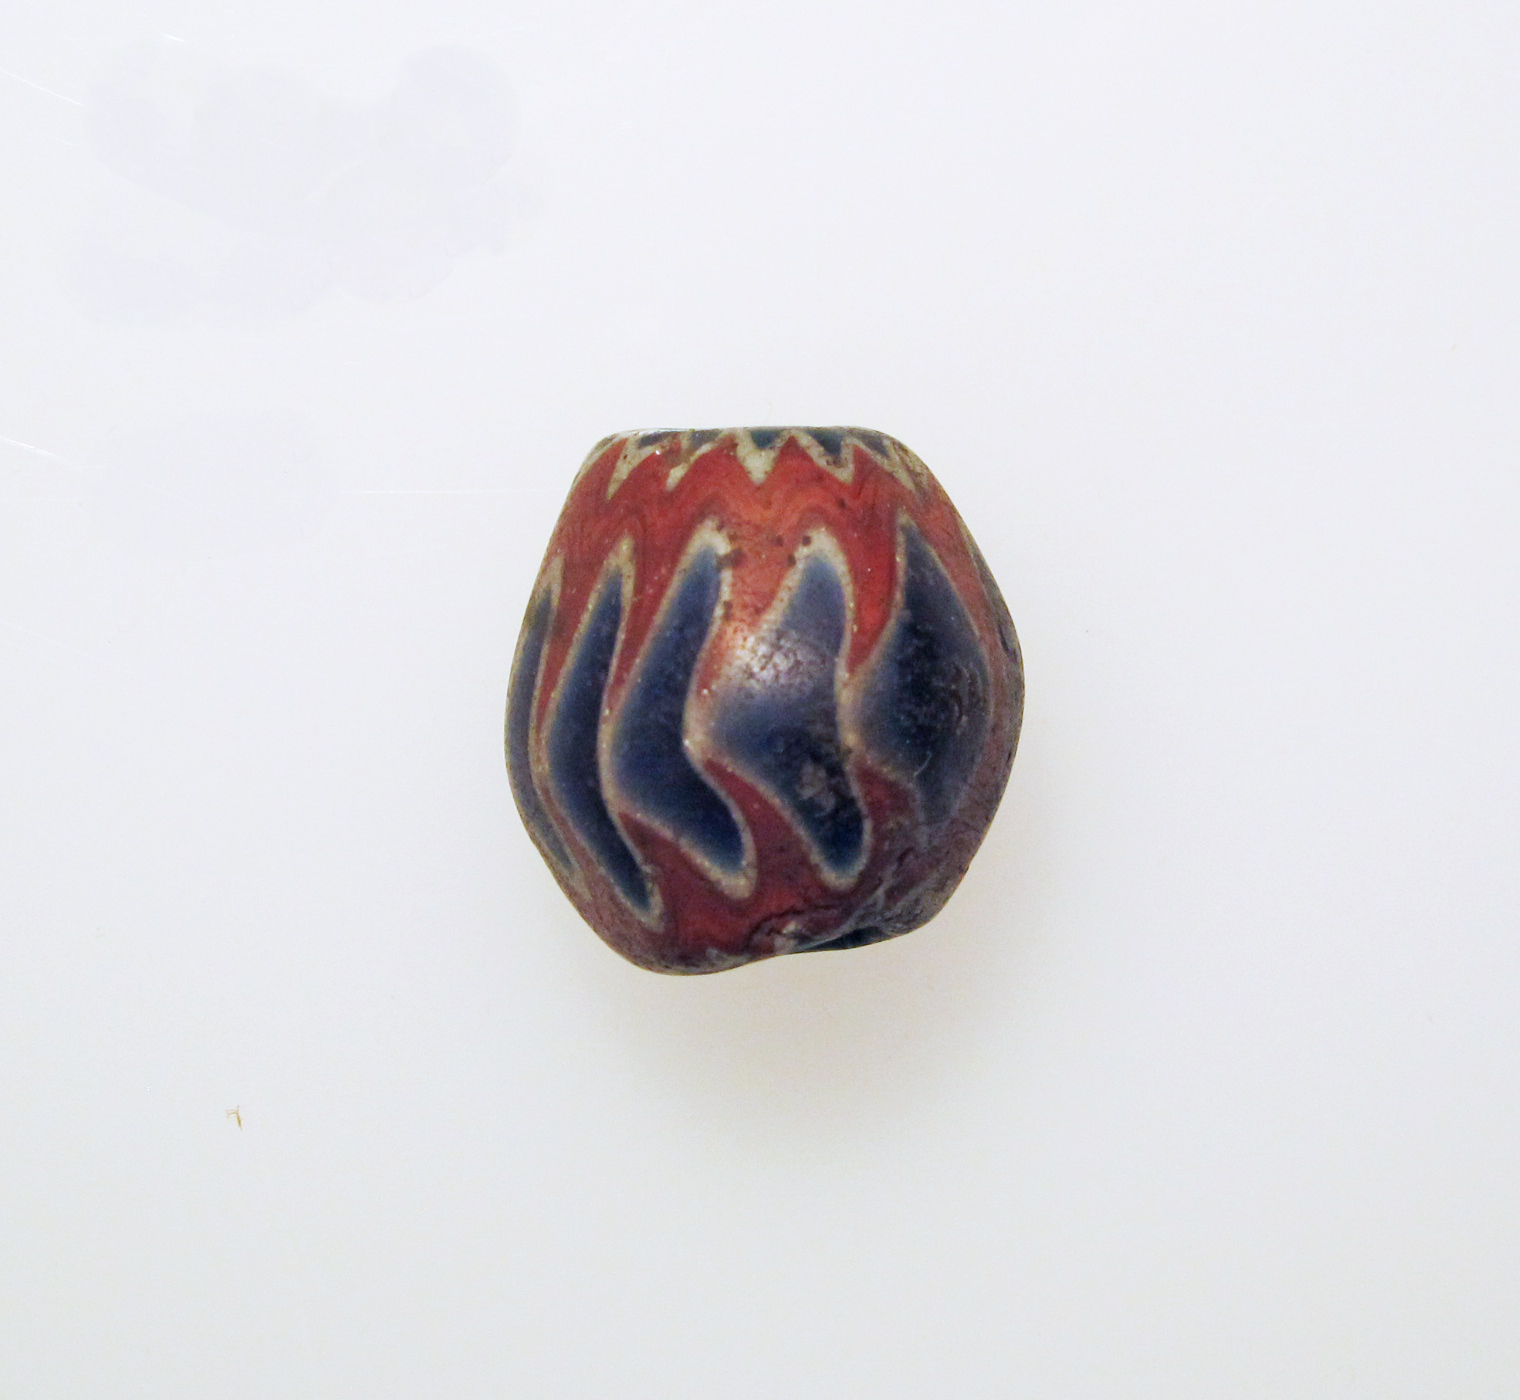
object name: chevron bead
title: Glass chevron bead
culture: venetian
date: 900-100 BCE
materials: glass